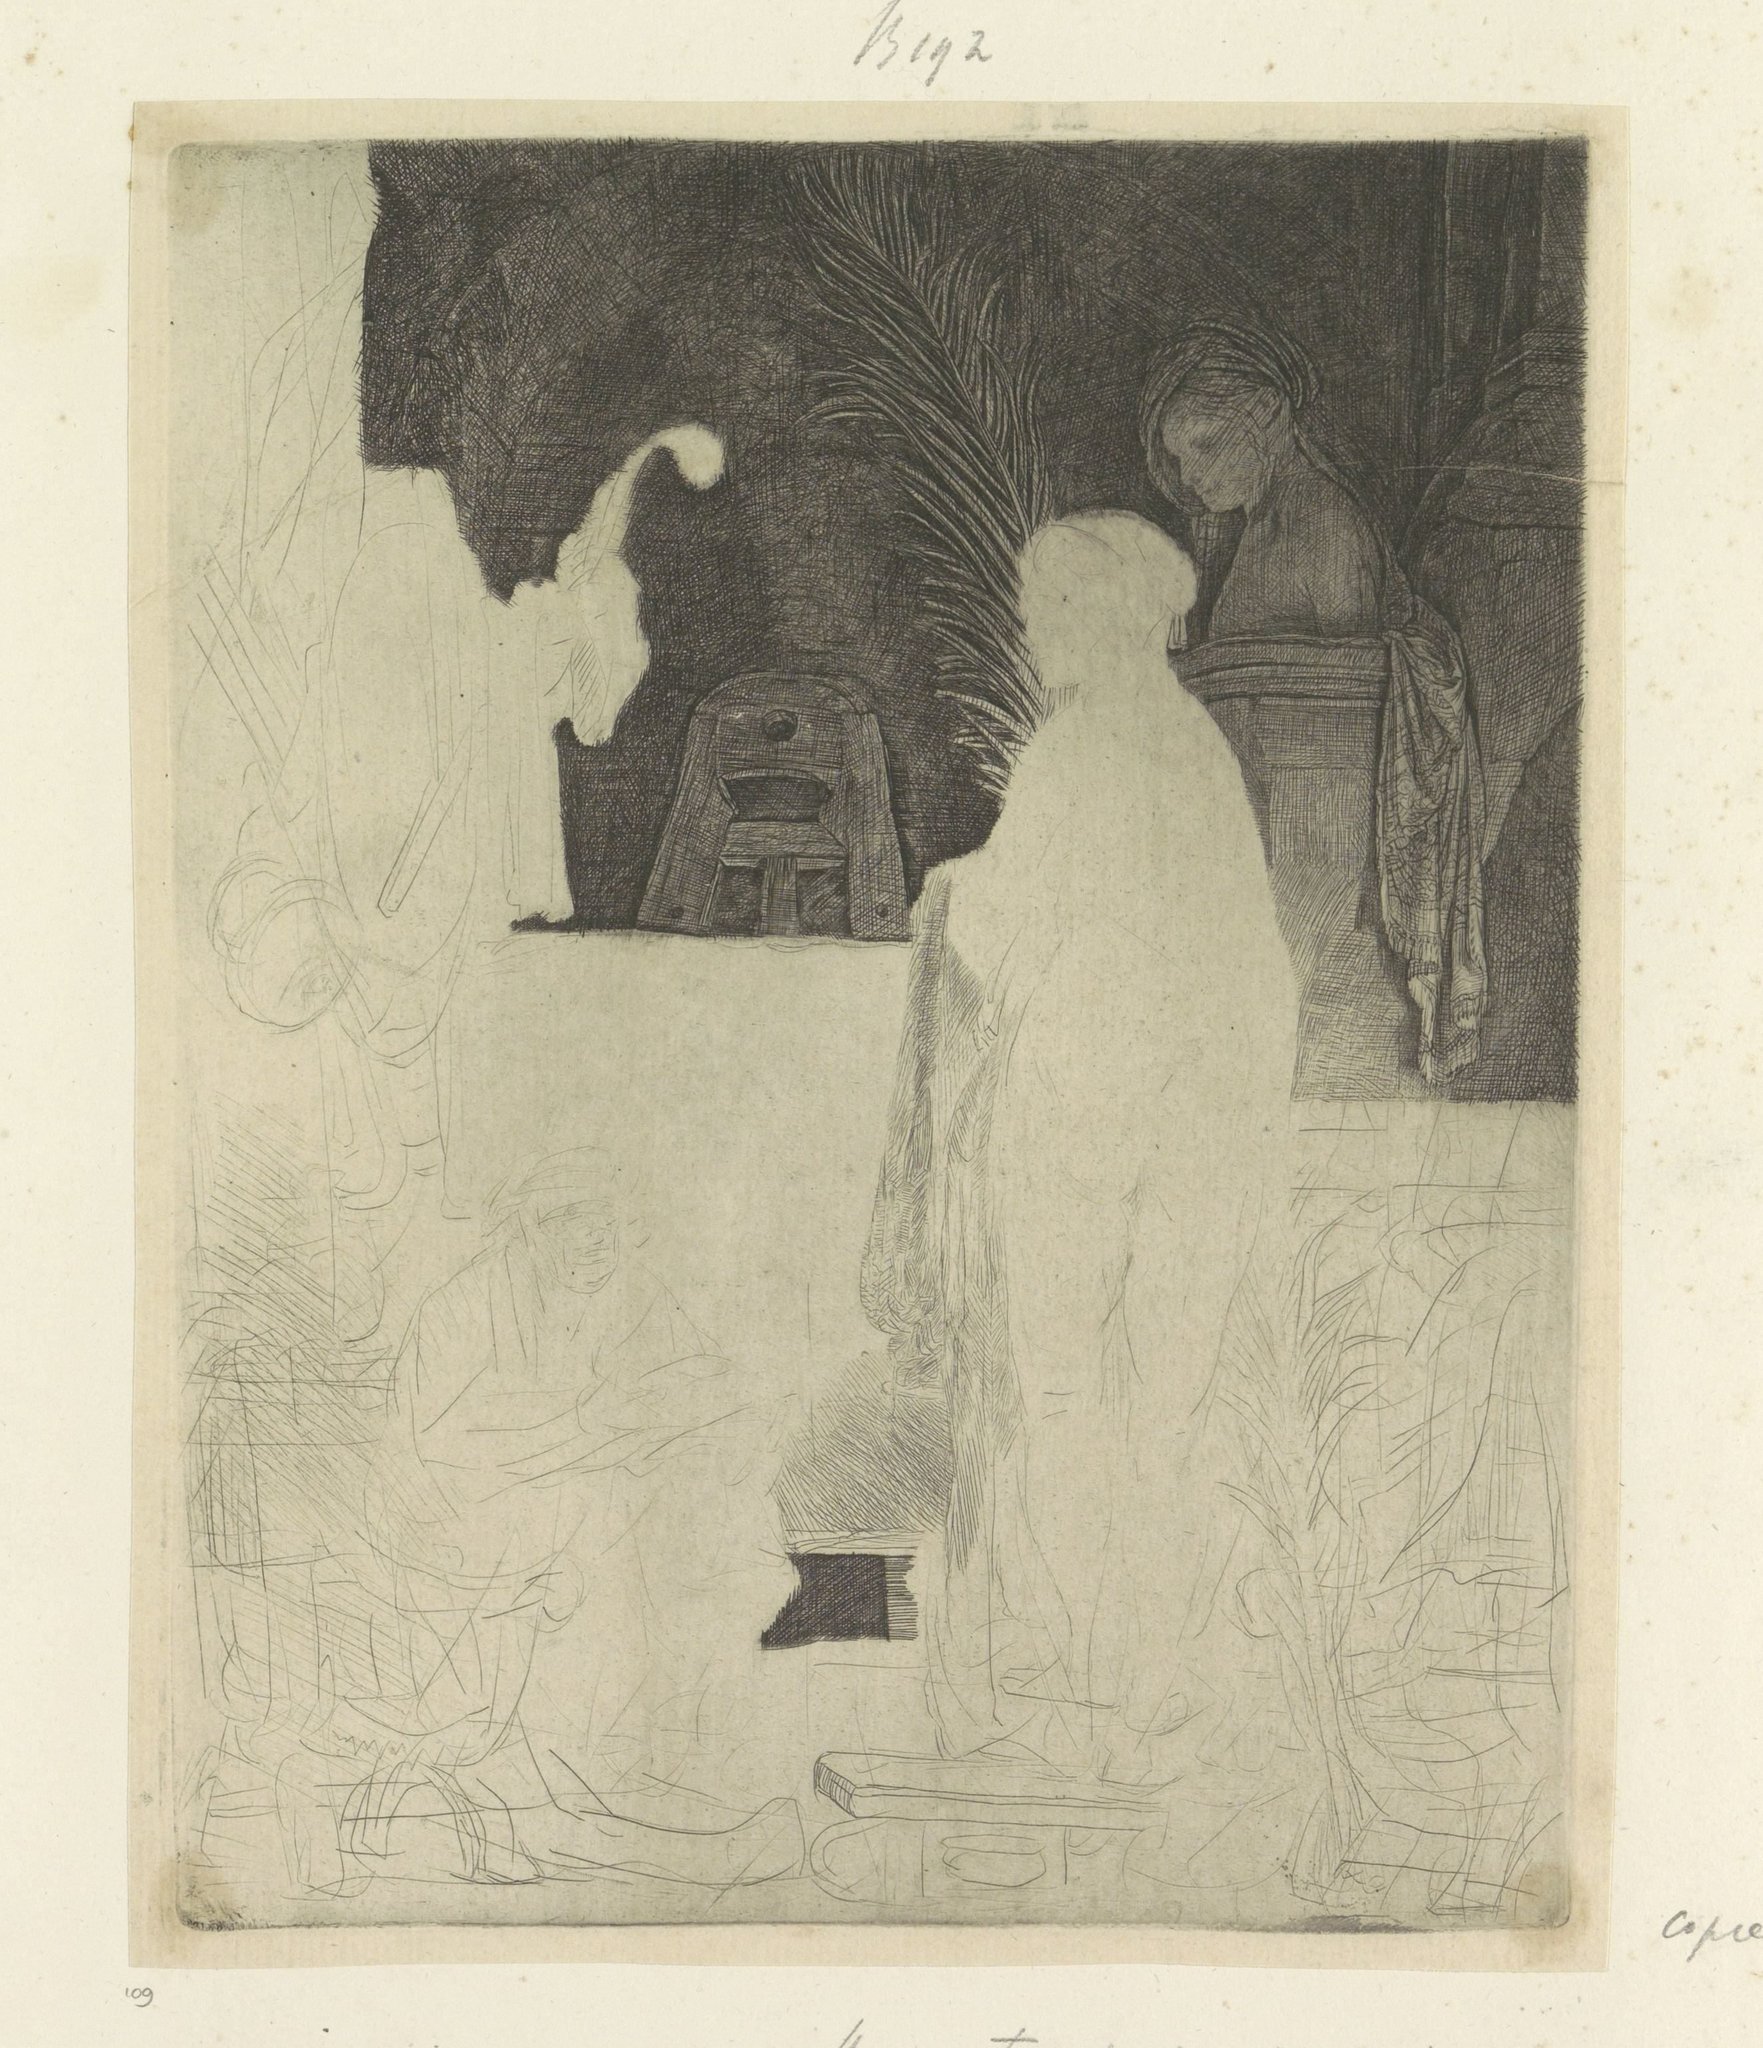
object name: print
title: Kunstenaar bezig met modeltekenen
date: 1637-1641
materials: paper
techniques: drypoint, etching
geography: paris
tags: artist (in general) working from live model